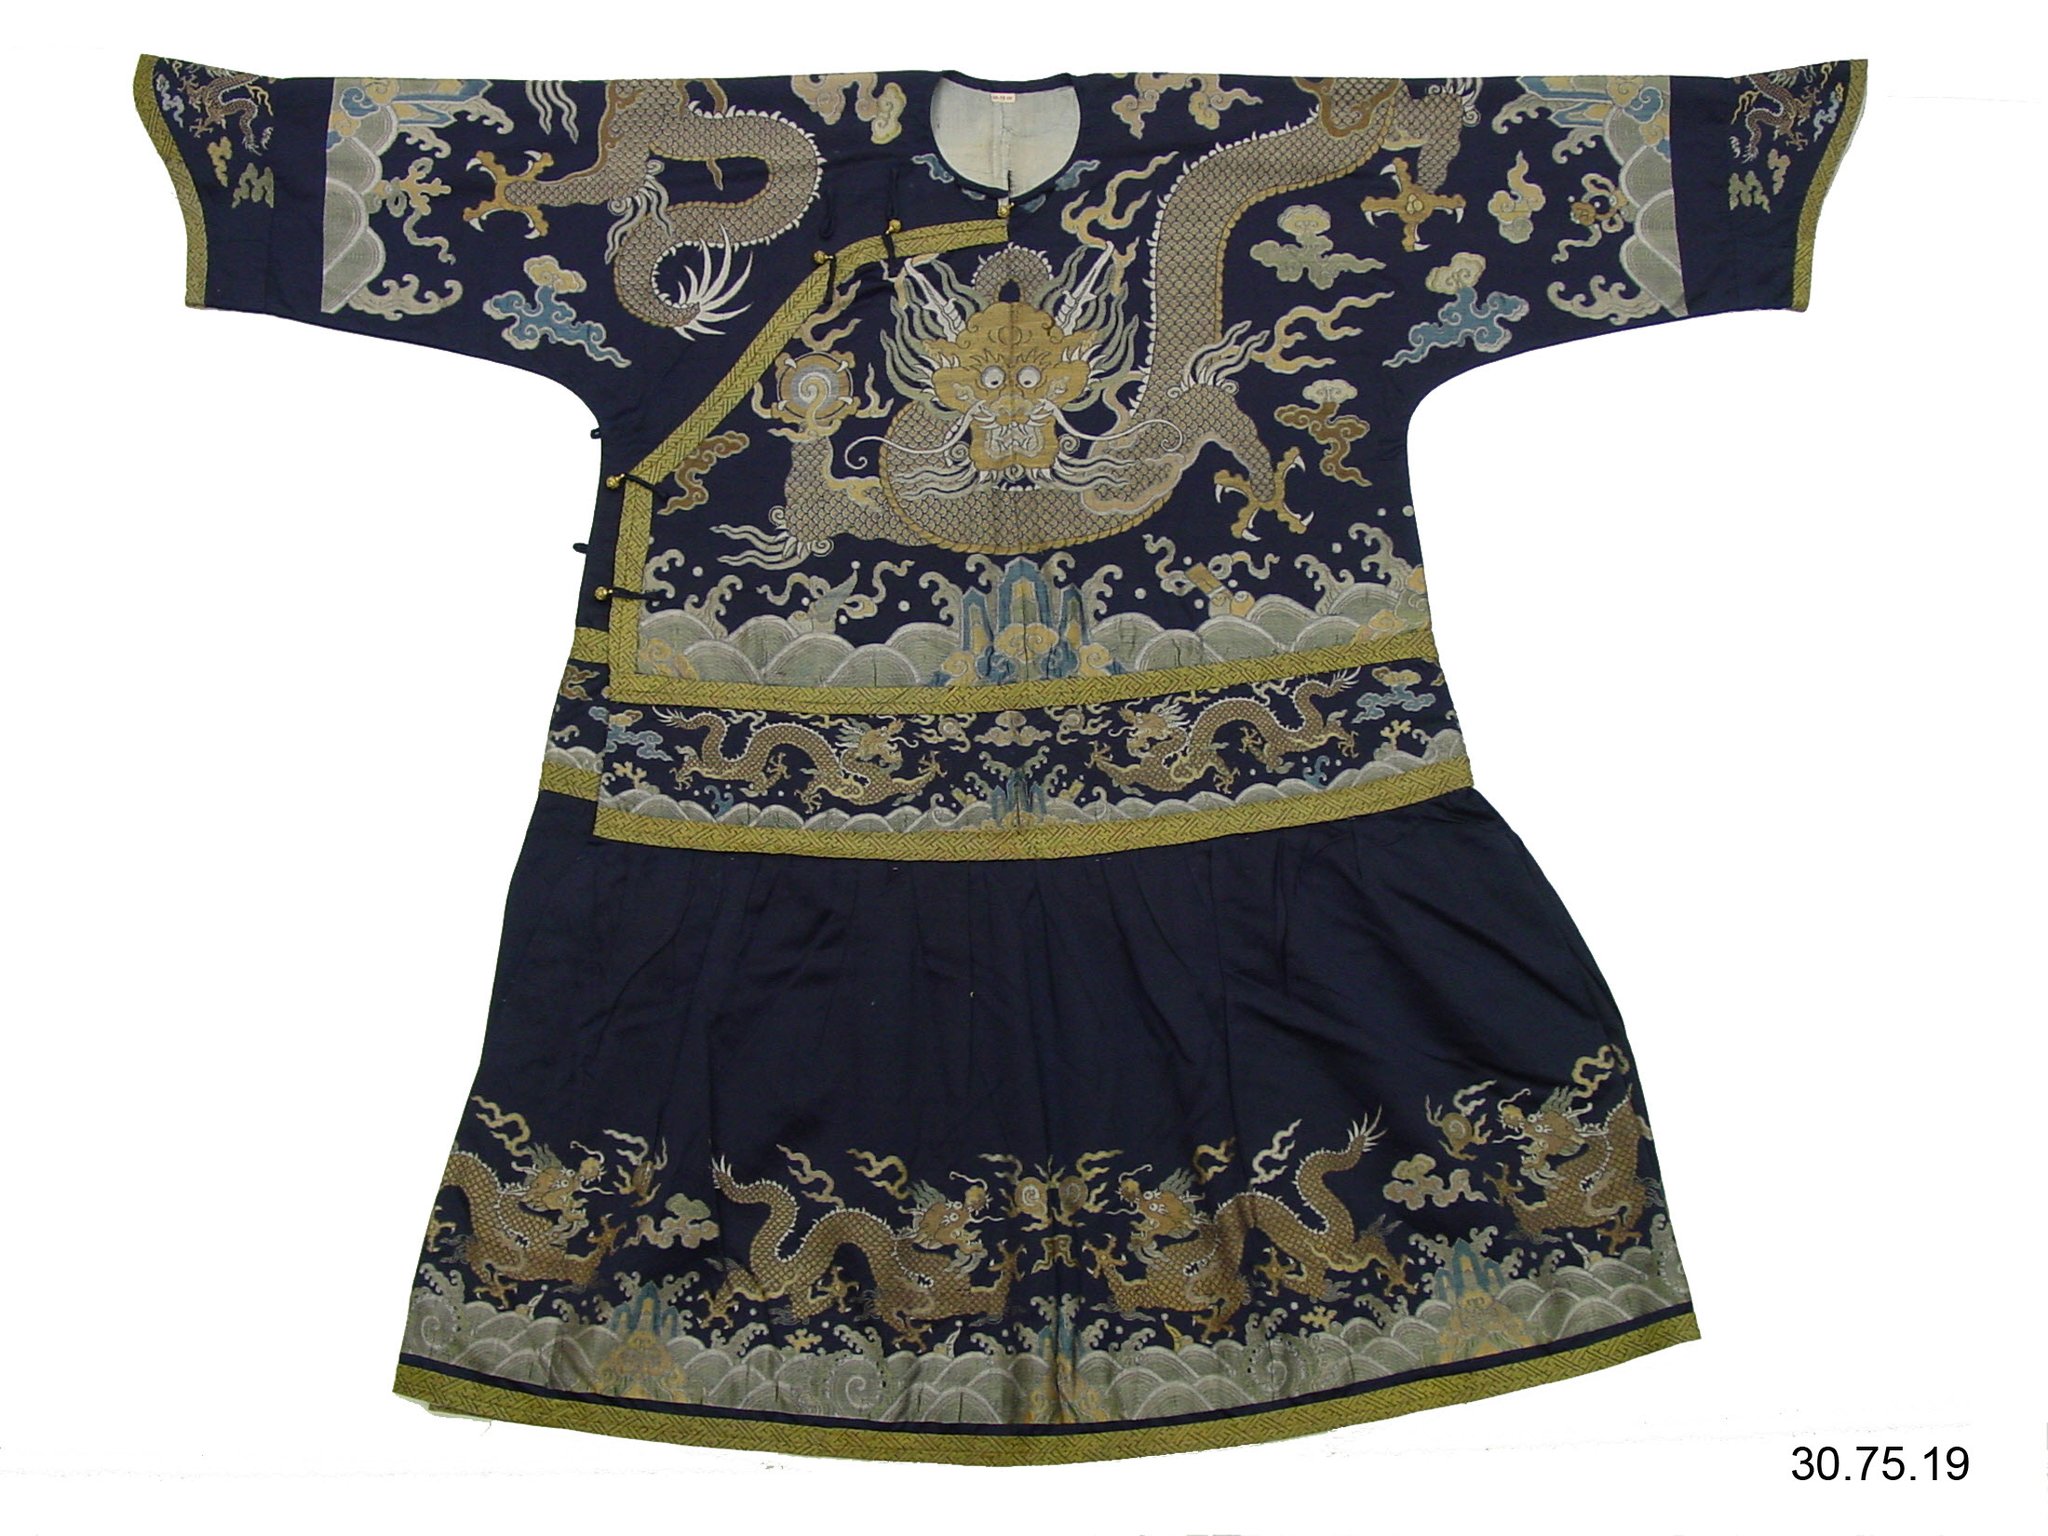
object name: robe of state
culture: chinese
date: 1601-1700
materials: silk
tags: dragons